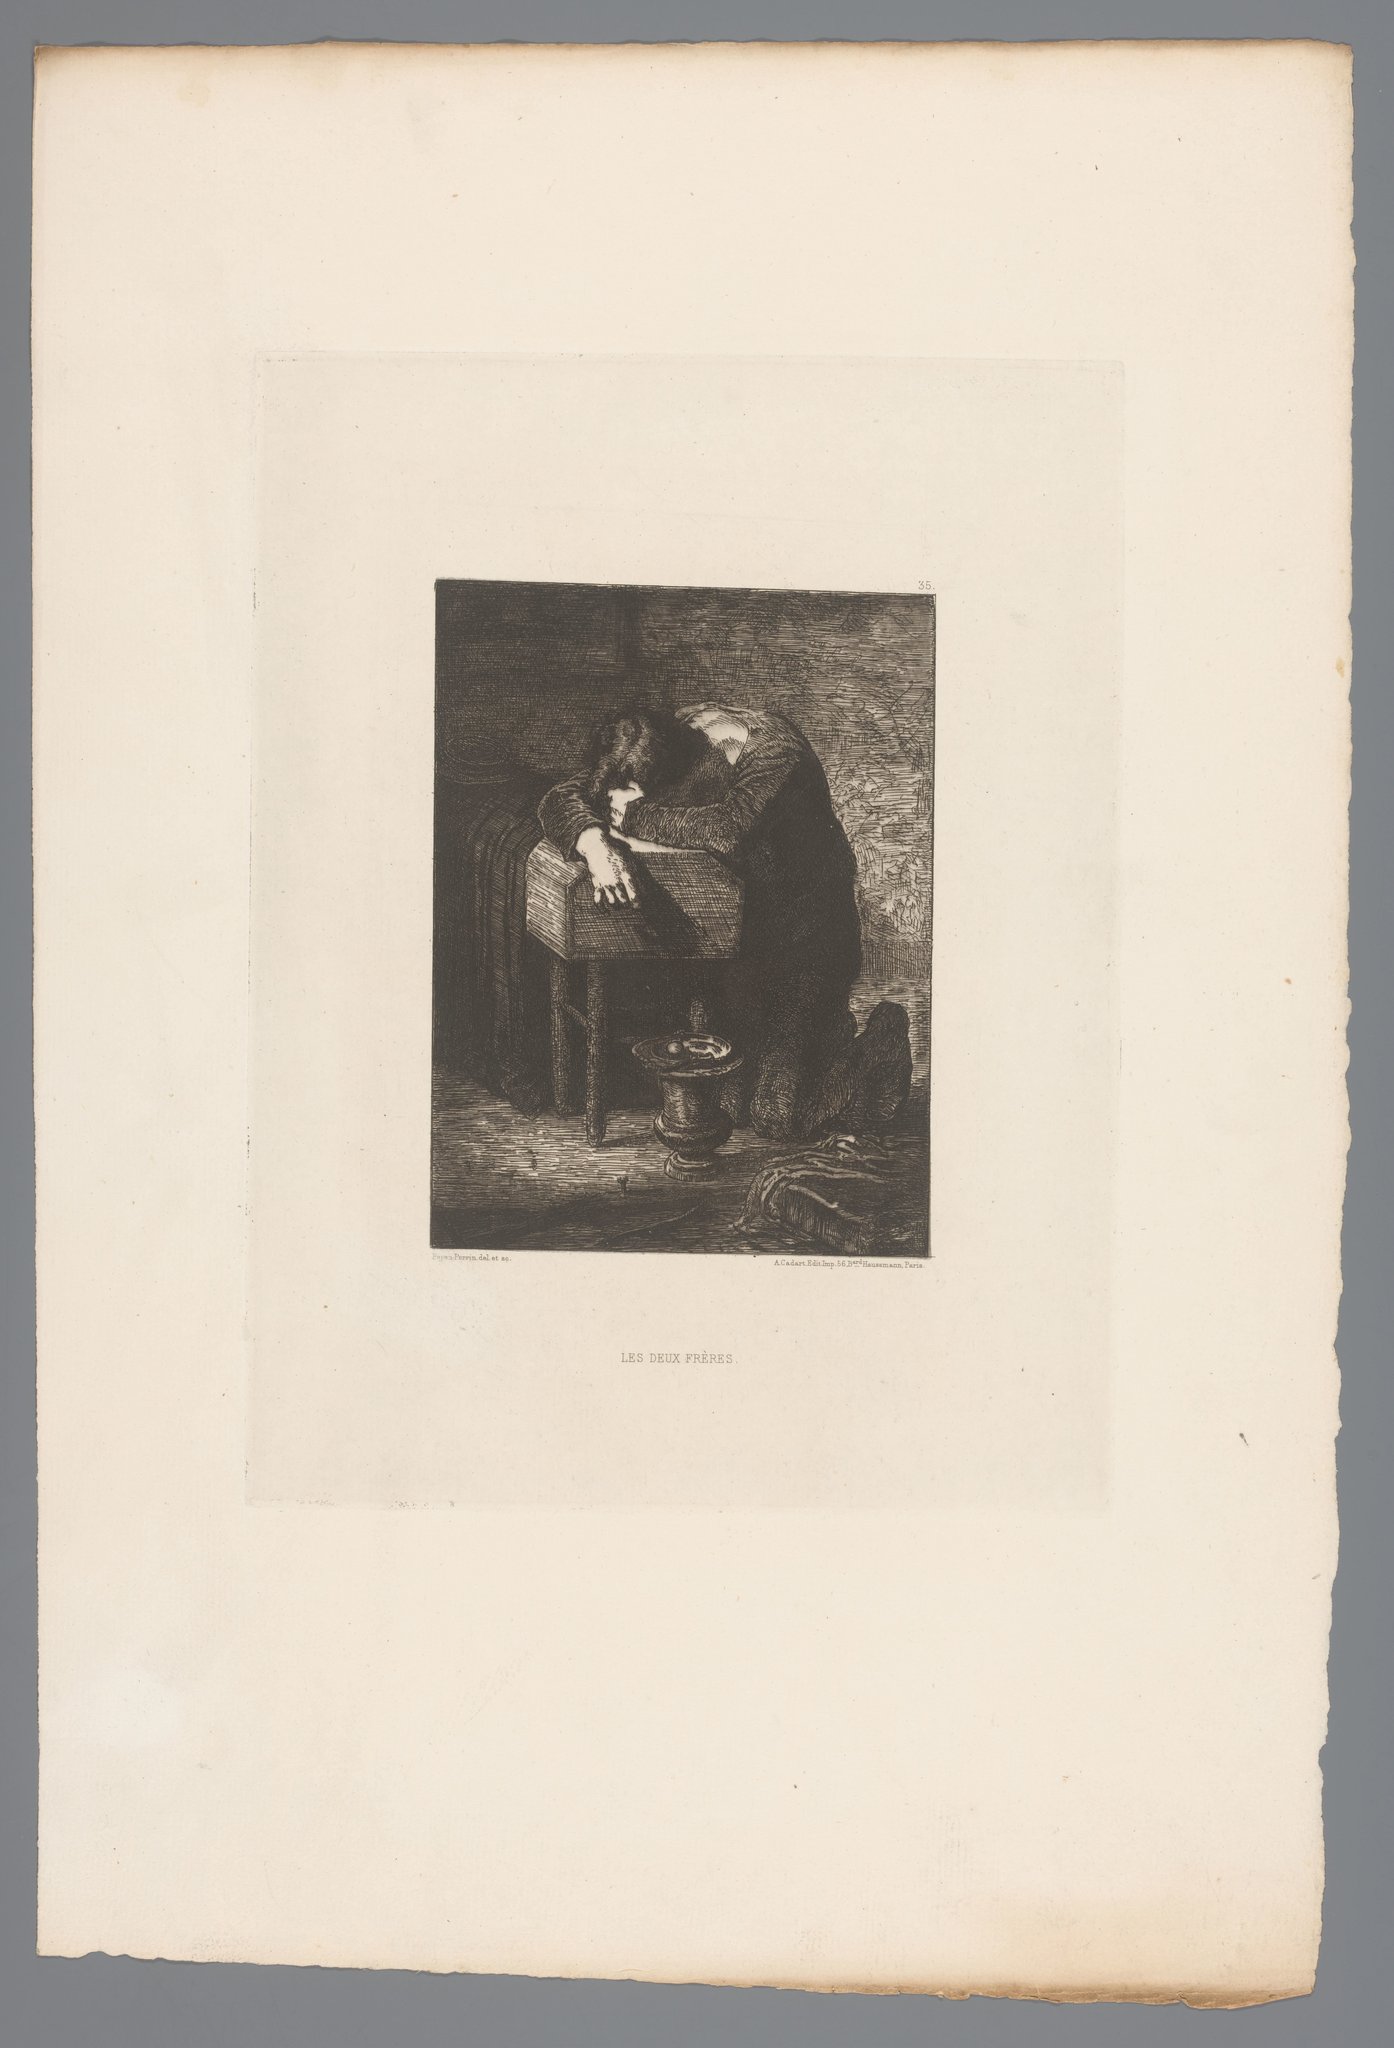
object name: print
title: Man huilend over een doodskist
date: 1875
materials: paper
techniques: drypoint, etching, intaglio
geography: paris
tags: weeping, mourning the dead, brothers (second degree family relationships)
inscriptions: collector's mark: ‘AFE v S’, collector's mark: Lugt 2228, collector's mark: Lugt 2760